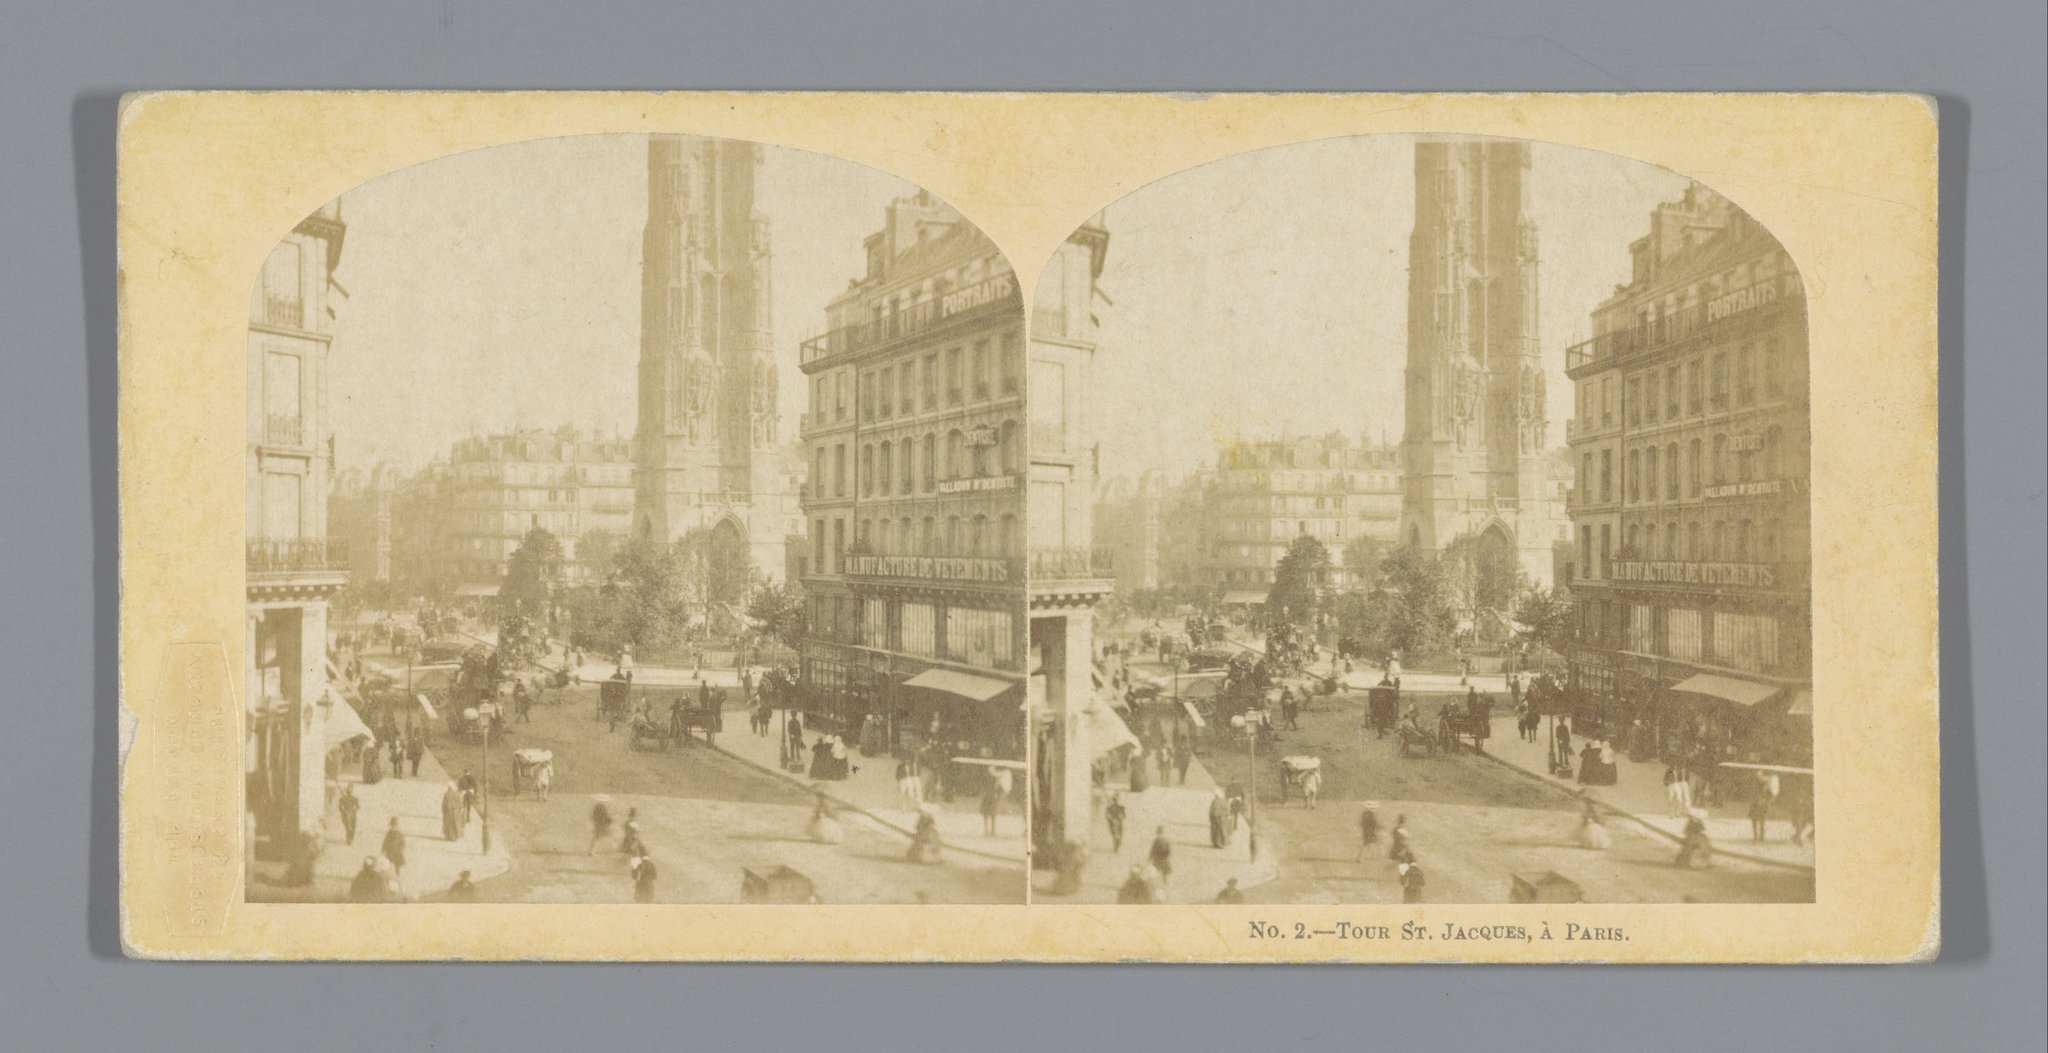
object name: stereograph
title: Gezicht op de Rue de Rivoli te Parijs, met op de achtergrond de Tour Saint-Jacques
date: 1850-1875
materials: cardboard, photographic support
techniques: albumen print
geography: rue de rivoli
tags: tower, clock tower ~ monumental adornment, avenue, boulevard, promenade, esplanade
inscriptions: number: ‘No. 2.’